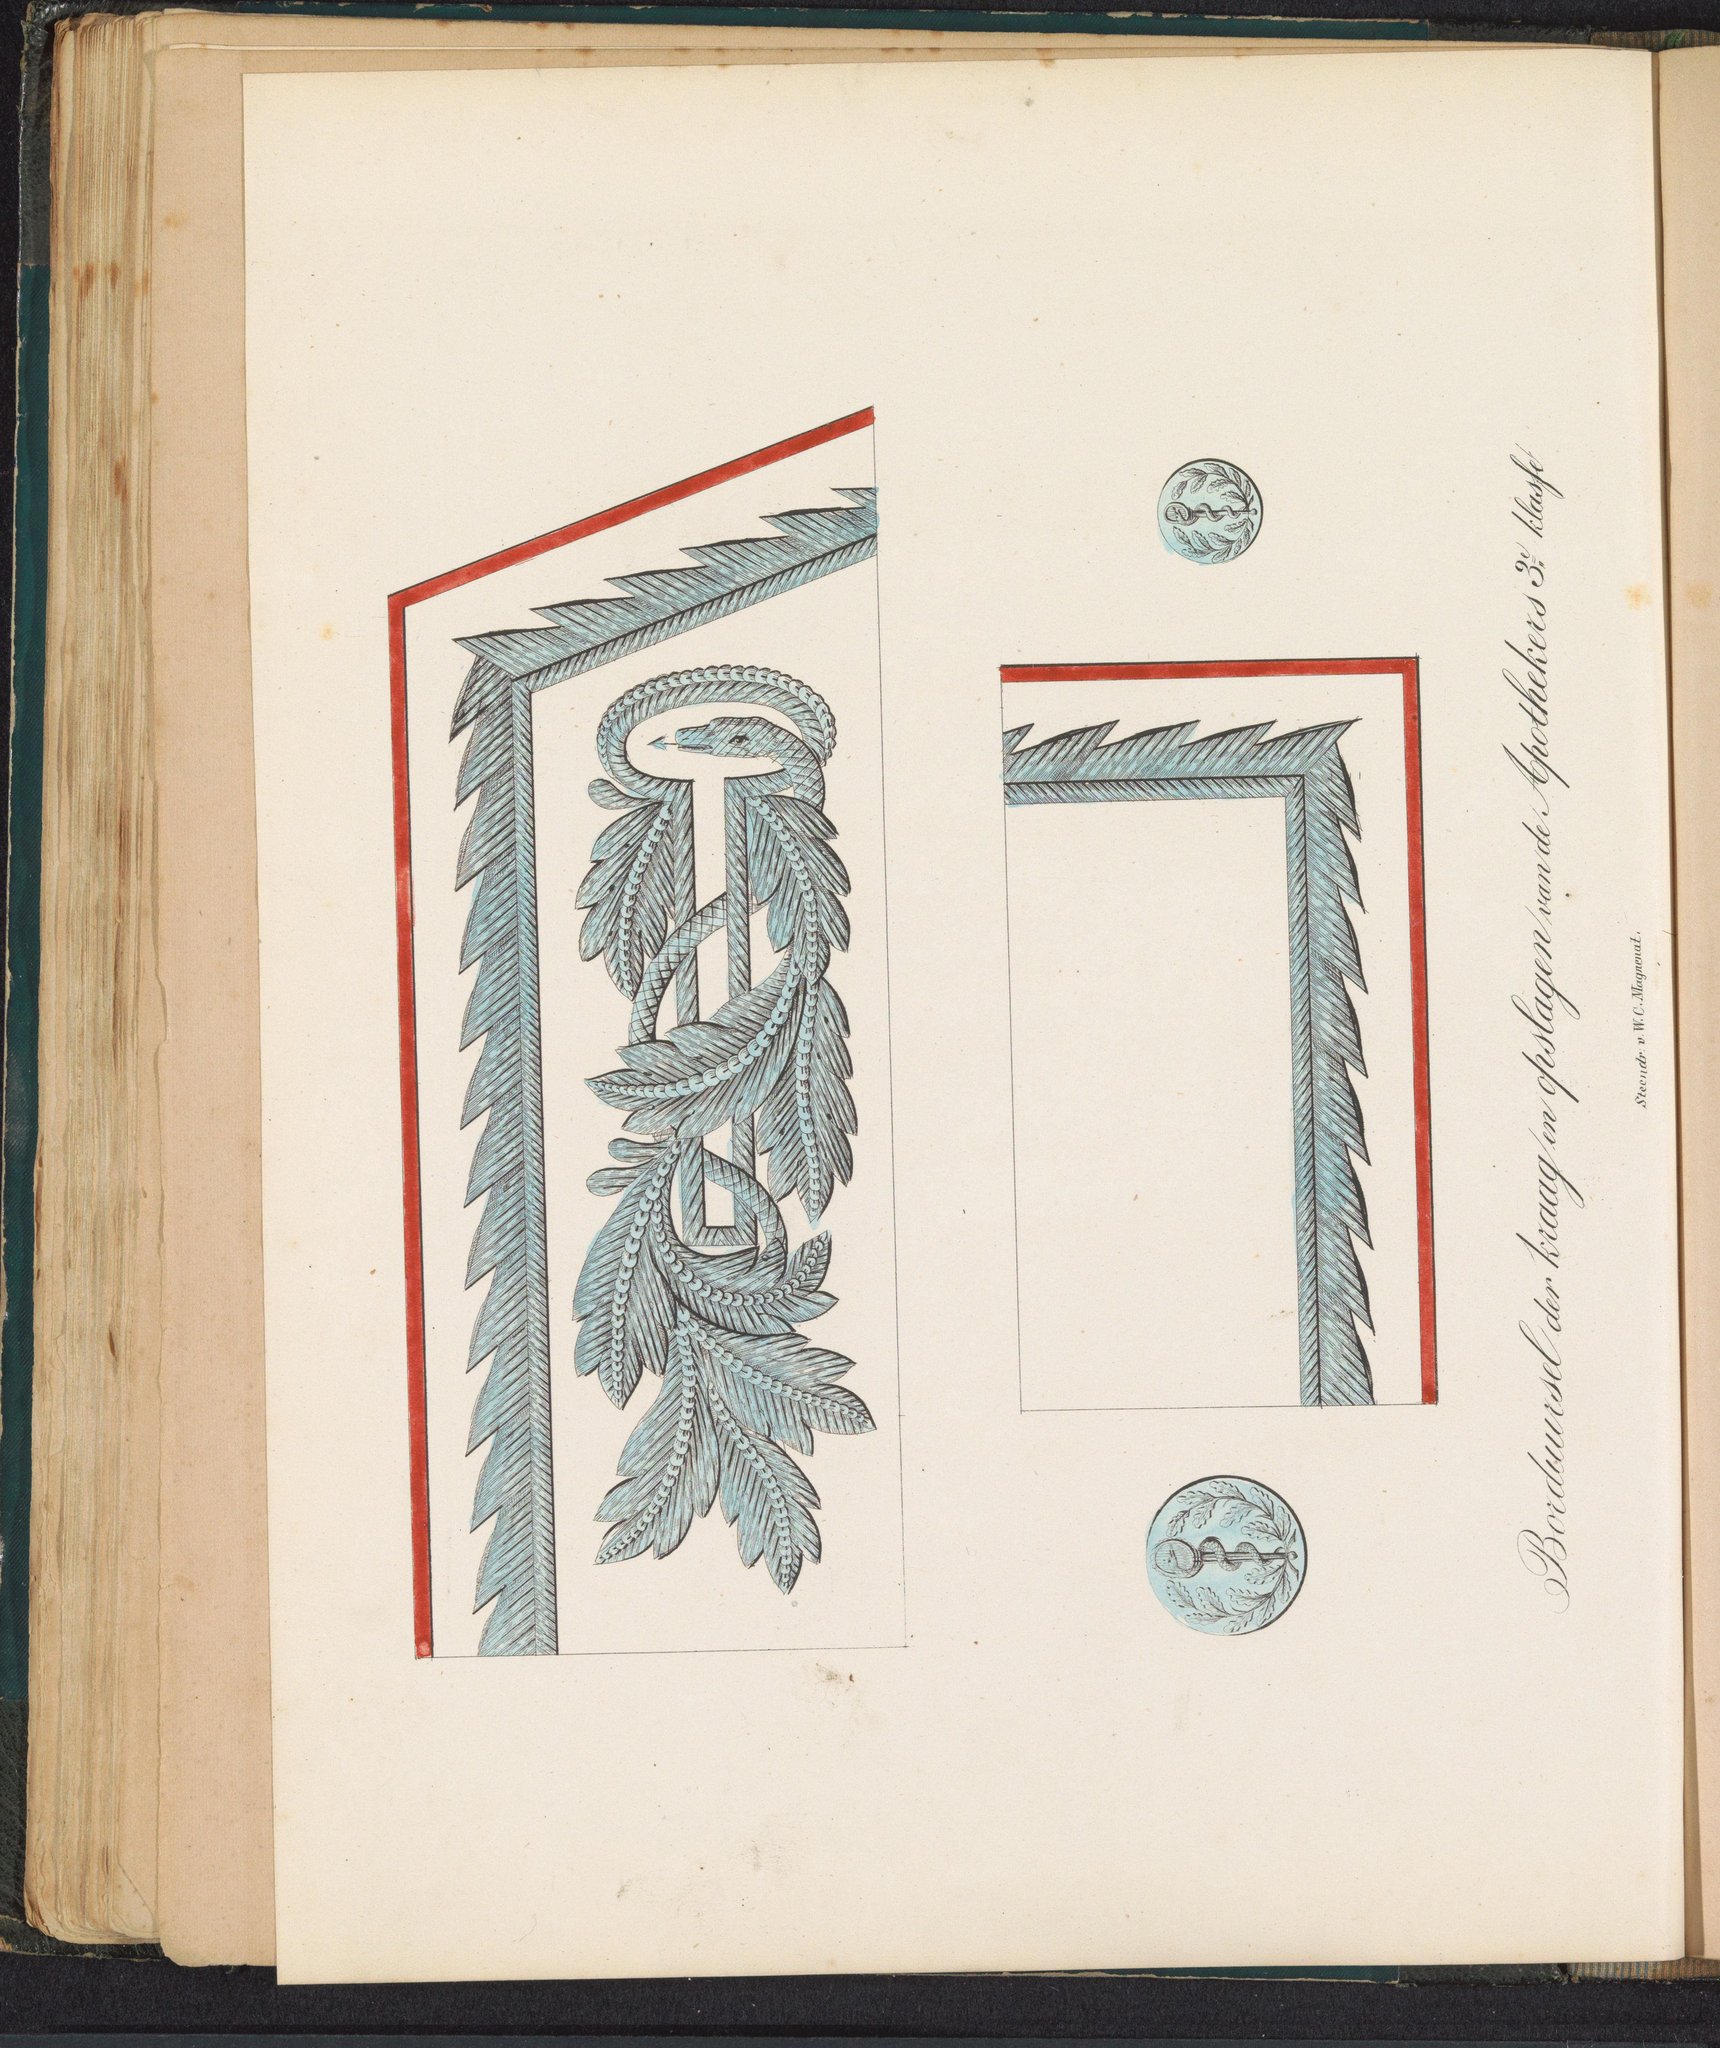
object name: book illustration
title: Borduursel op het uniform van apothekers van de Geneeskundige Dienst, 1845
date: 1845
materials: paper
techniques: hand coloring, lithograph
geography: netherlands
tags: (military) uniforms, netherlands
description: Borduursel op het uniform van apothekers van de Geneeskundige Dienst. Illustratie in een boek uit 1845 over de uniformen en kledingstukken van de Nederlandse land-, zeemacht en schutterijen in Nederland en in de overzeese gebiedsdelen.